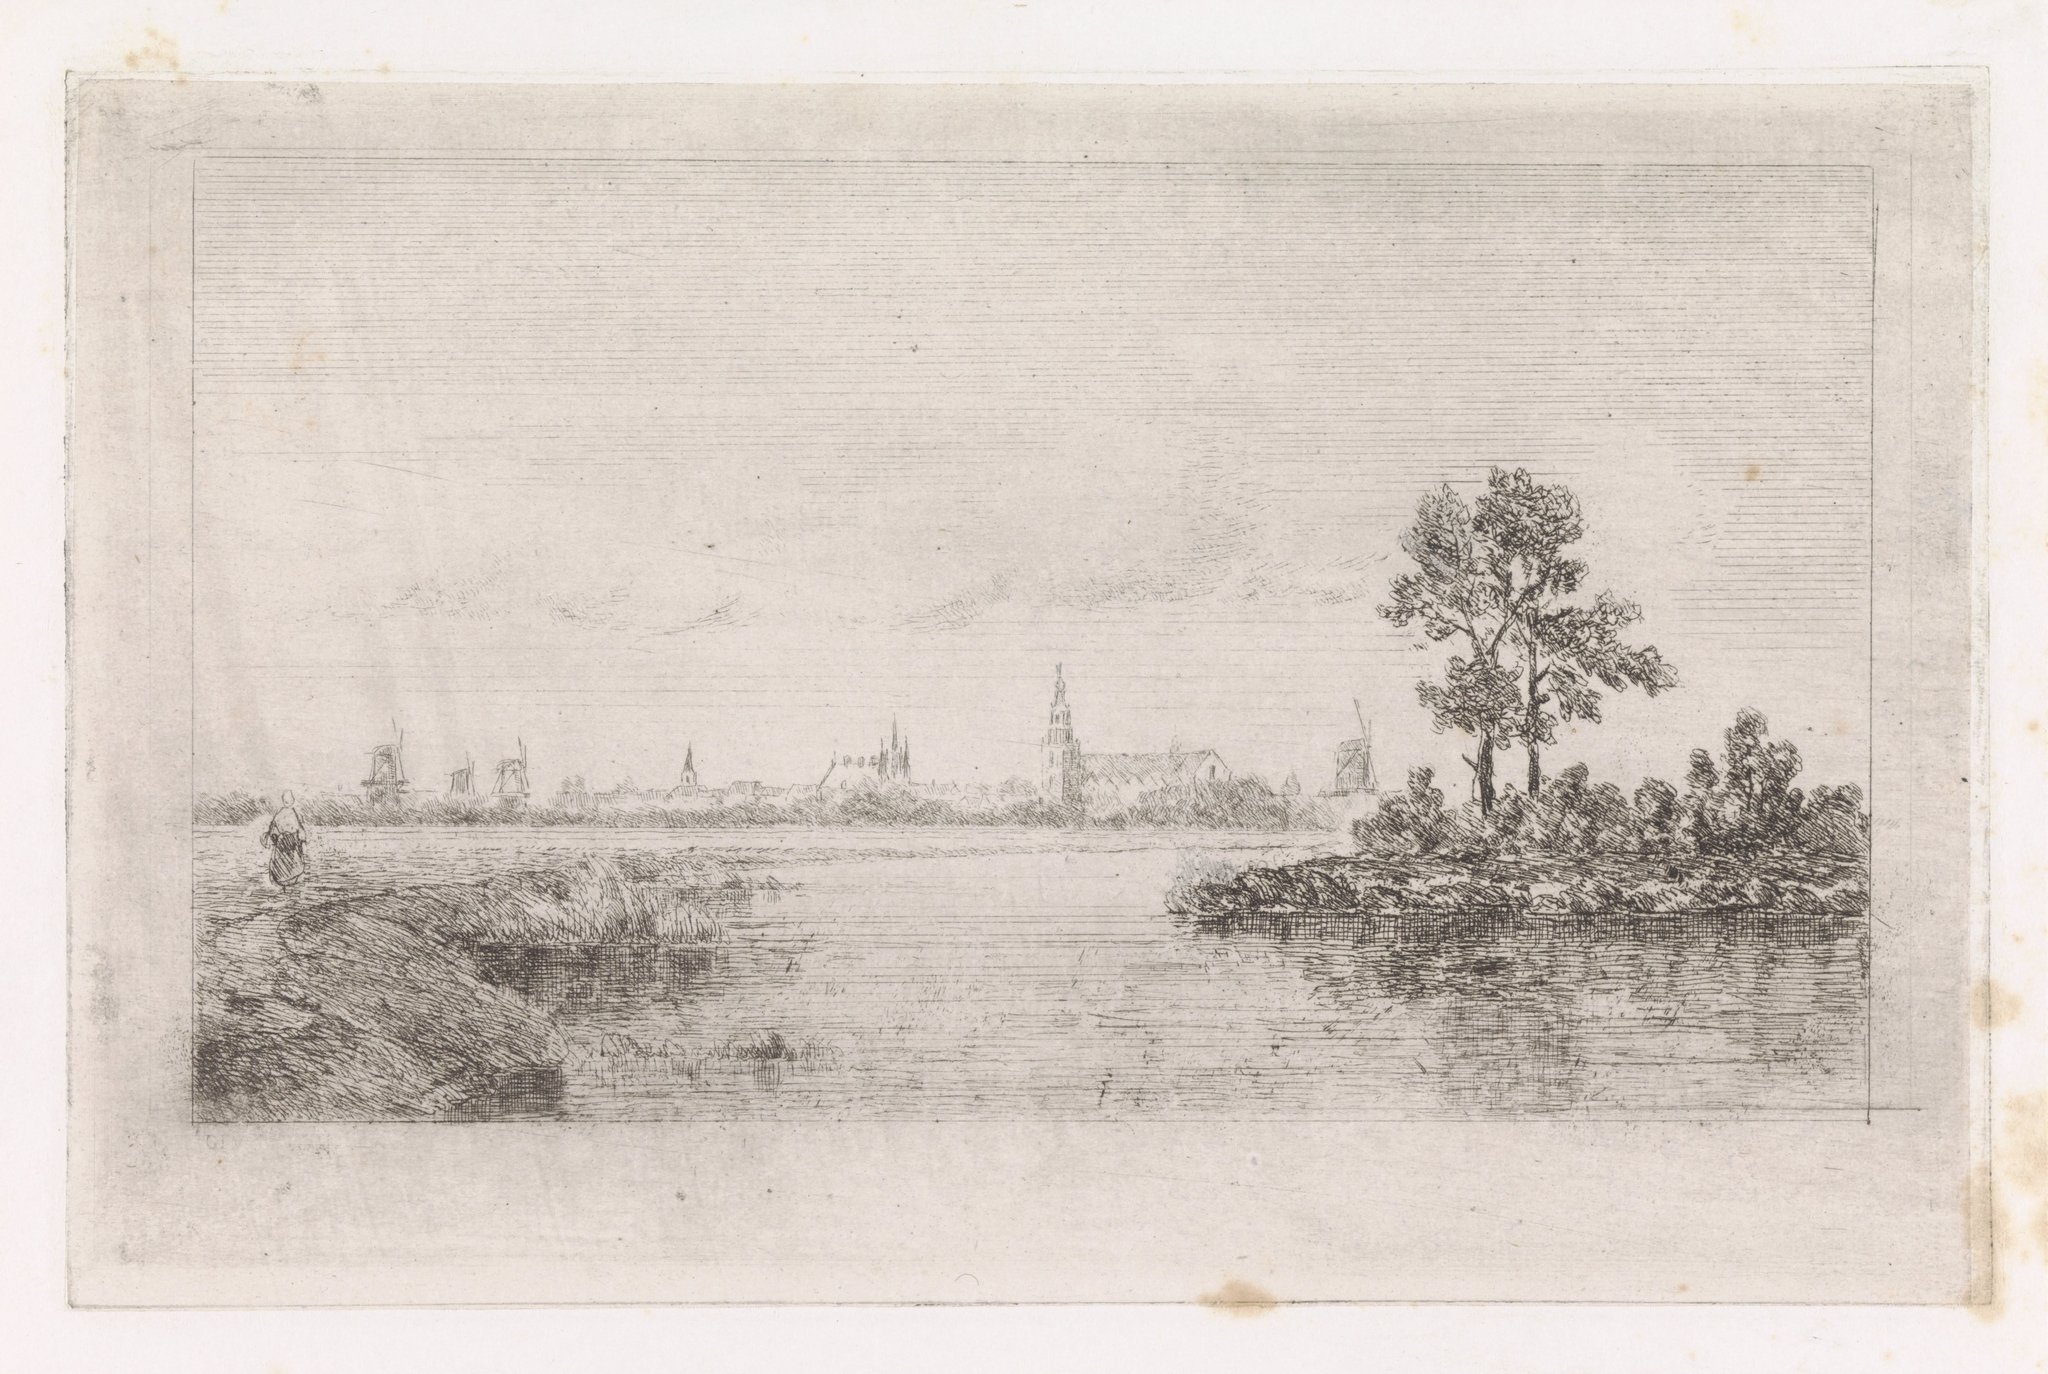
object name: print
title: Rivierlandschap met stadsprofiel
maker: gijsbertus johannes verspuy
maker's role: print maker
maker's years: 1823-1862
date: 1833-1862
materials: paper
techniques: etching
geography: netherlands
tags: river, prospect of city, town panorama, silhouette of city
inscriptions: collector's mark: Lugt 1485, collector's mark: Lugt 2228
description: Gezicht op een rivier met aan de horizon een stad. Links een vrouwenfiguur op de oever.